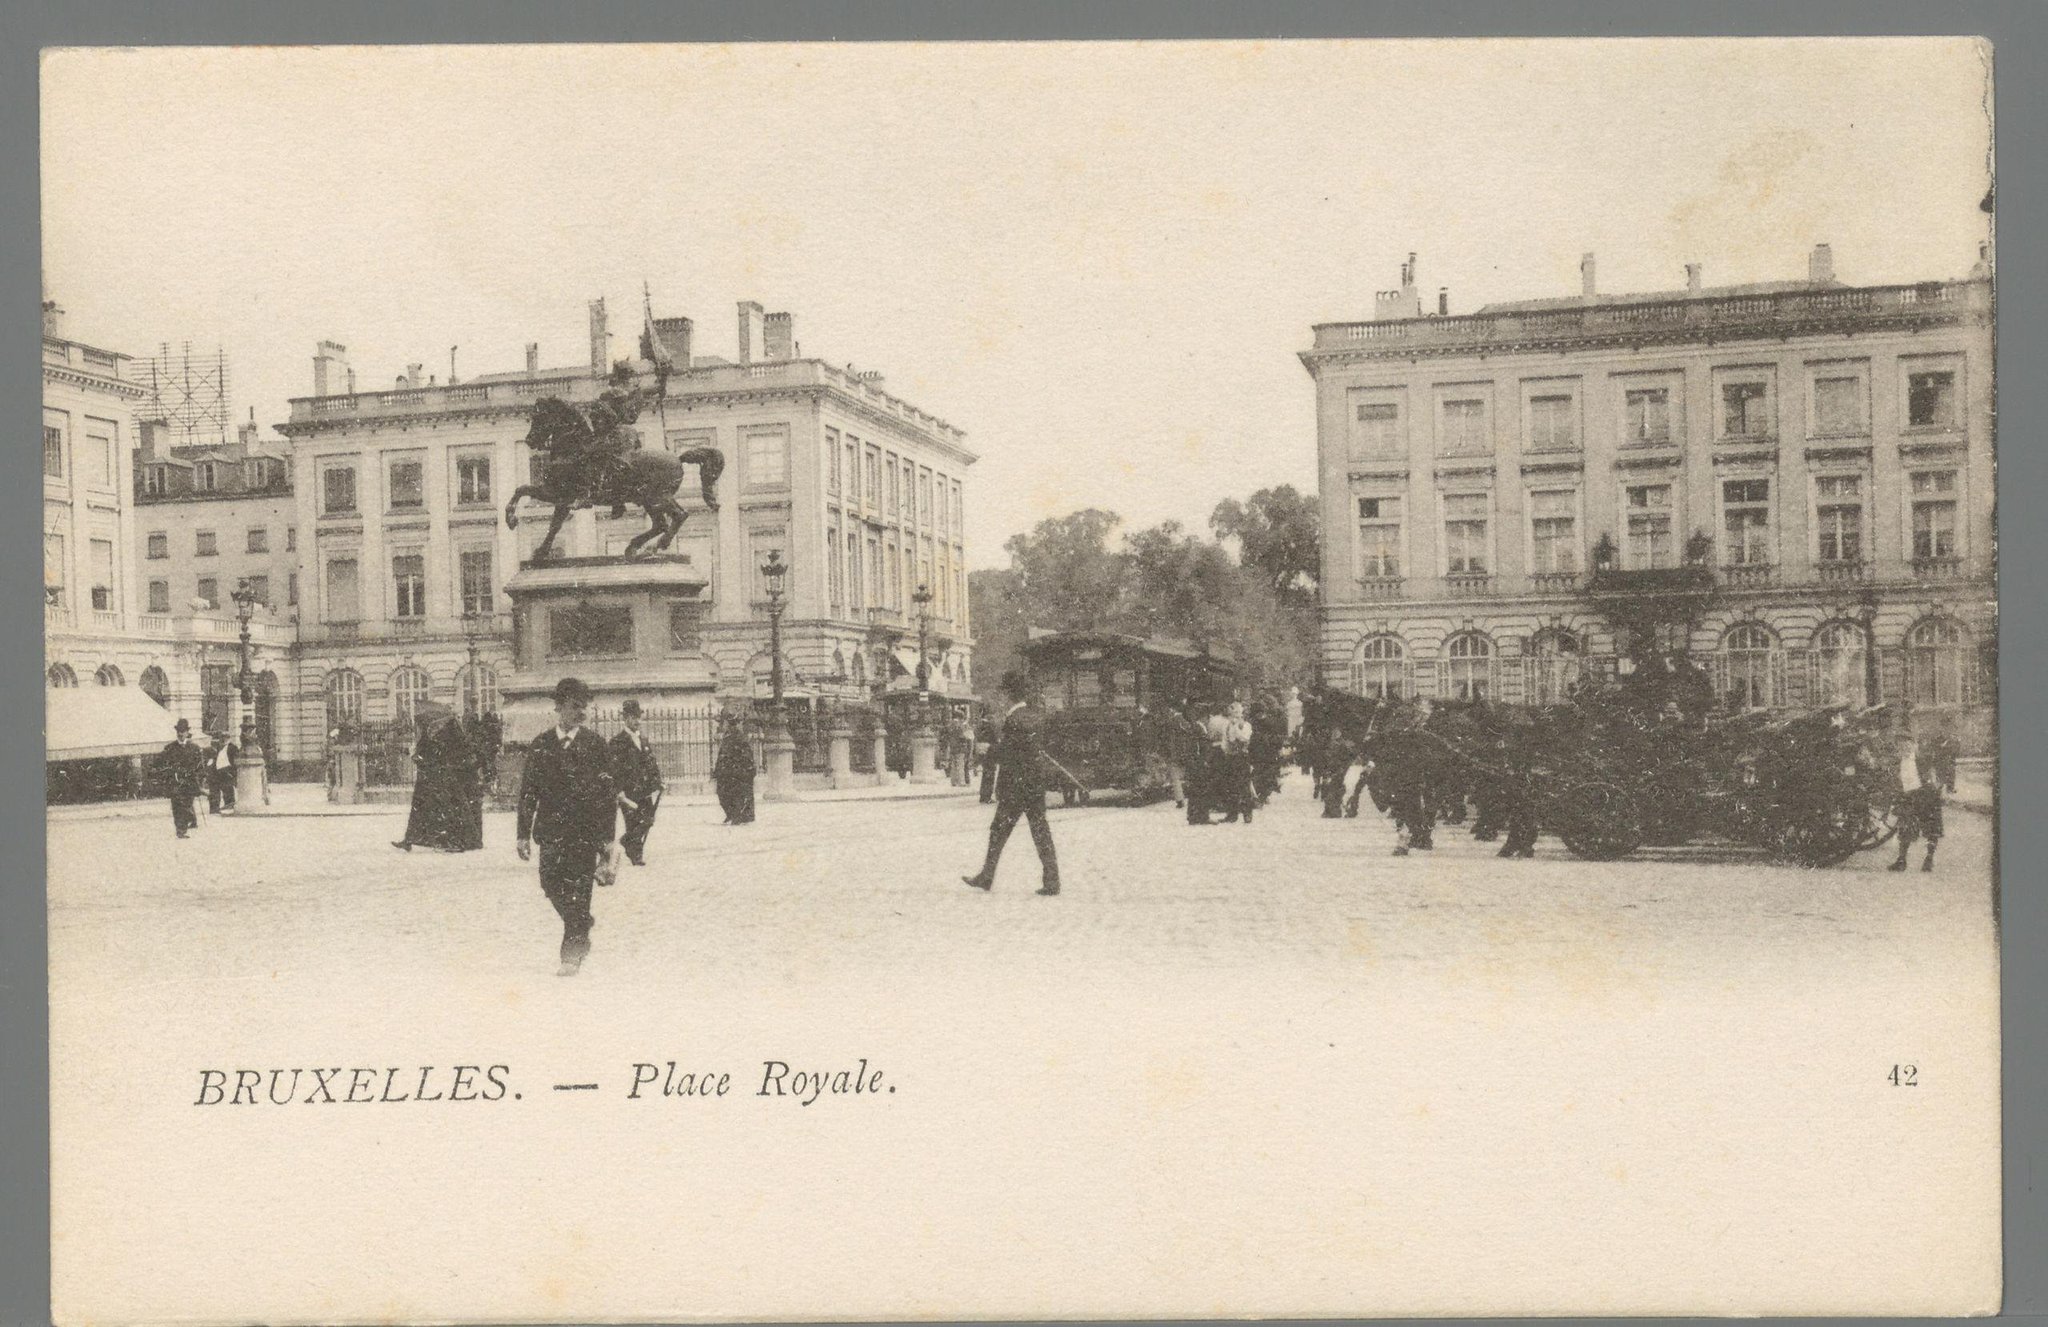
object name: ansichtkaart, prentbriefkaart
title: Bruxelles. Place Royale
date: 1900-1906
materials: cardboard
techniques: photograph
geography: brussels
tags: monument, statue, square, place, circus, etc. (+ city(-scape) with figures, staffage)